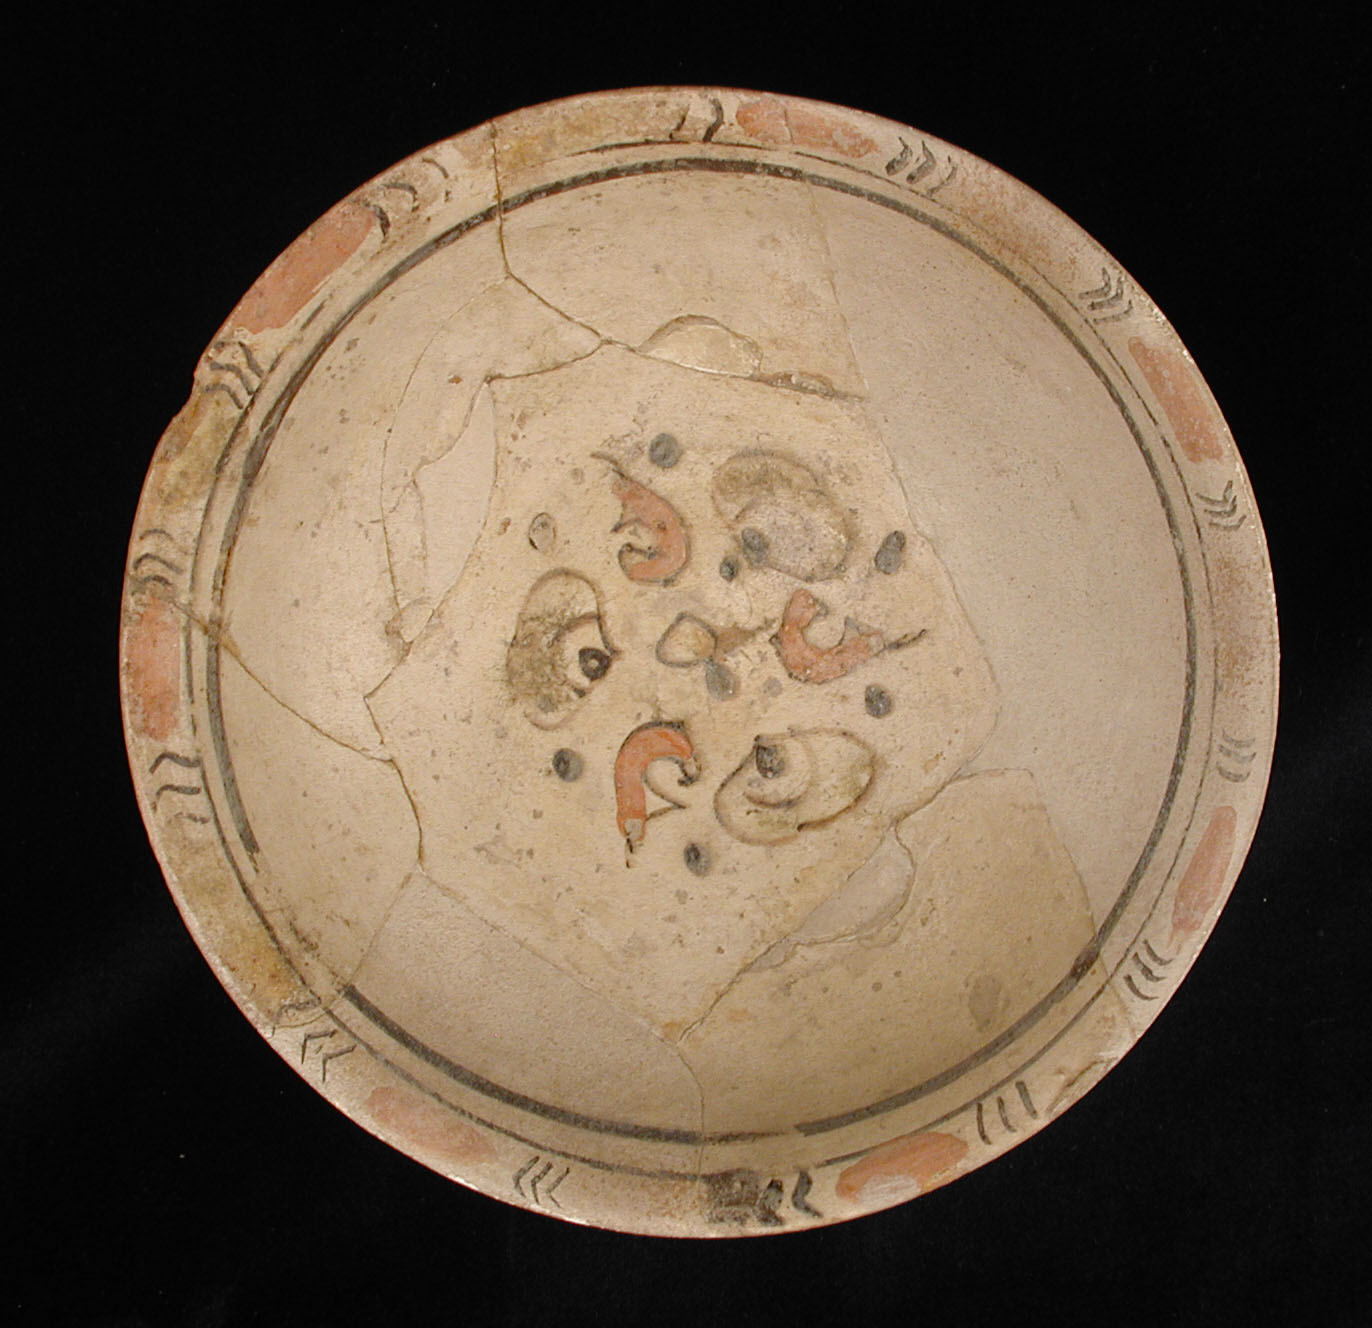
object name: bowl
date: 801-900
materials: earthenware, glaze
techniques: polychrome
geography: iran